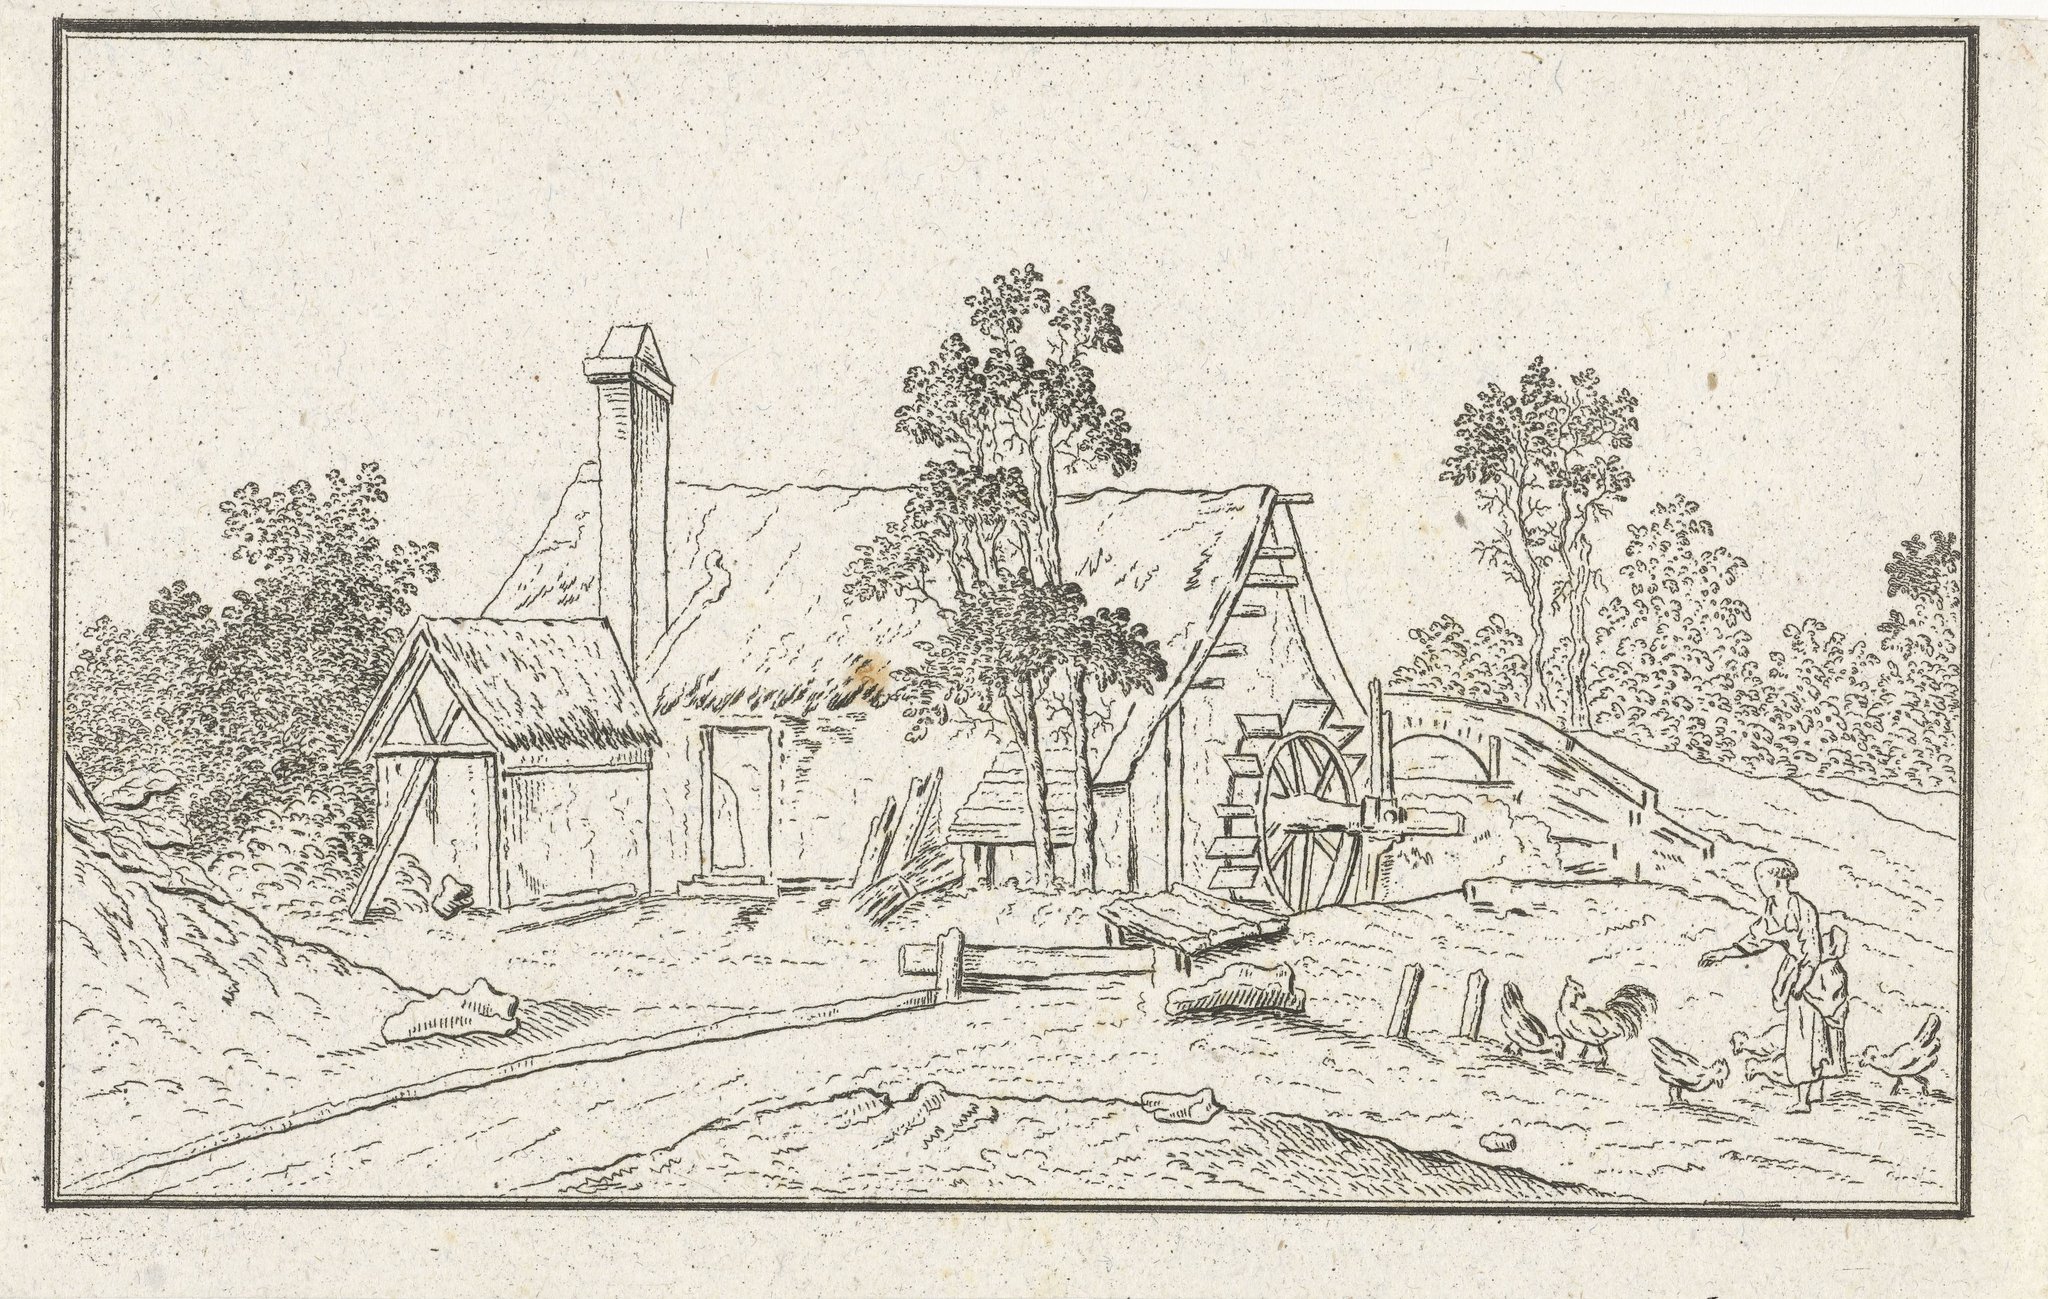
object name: print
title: Landschap met boerderij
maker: christian friedrich fritzsch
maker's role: print maker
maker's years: 1719-1774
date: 1729-1774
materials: paper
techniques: etching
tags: farm or solitary house in landscape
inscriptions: collector's mark: Lugt 2228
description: Gezicht op een boerderij in een landschap, rechts geeft een figuur op het erf kippen te eten.